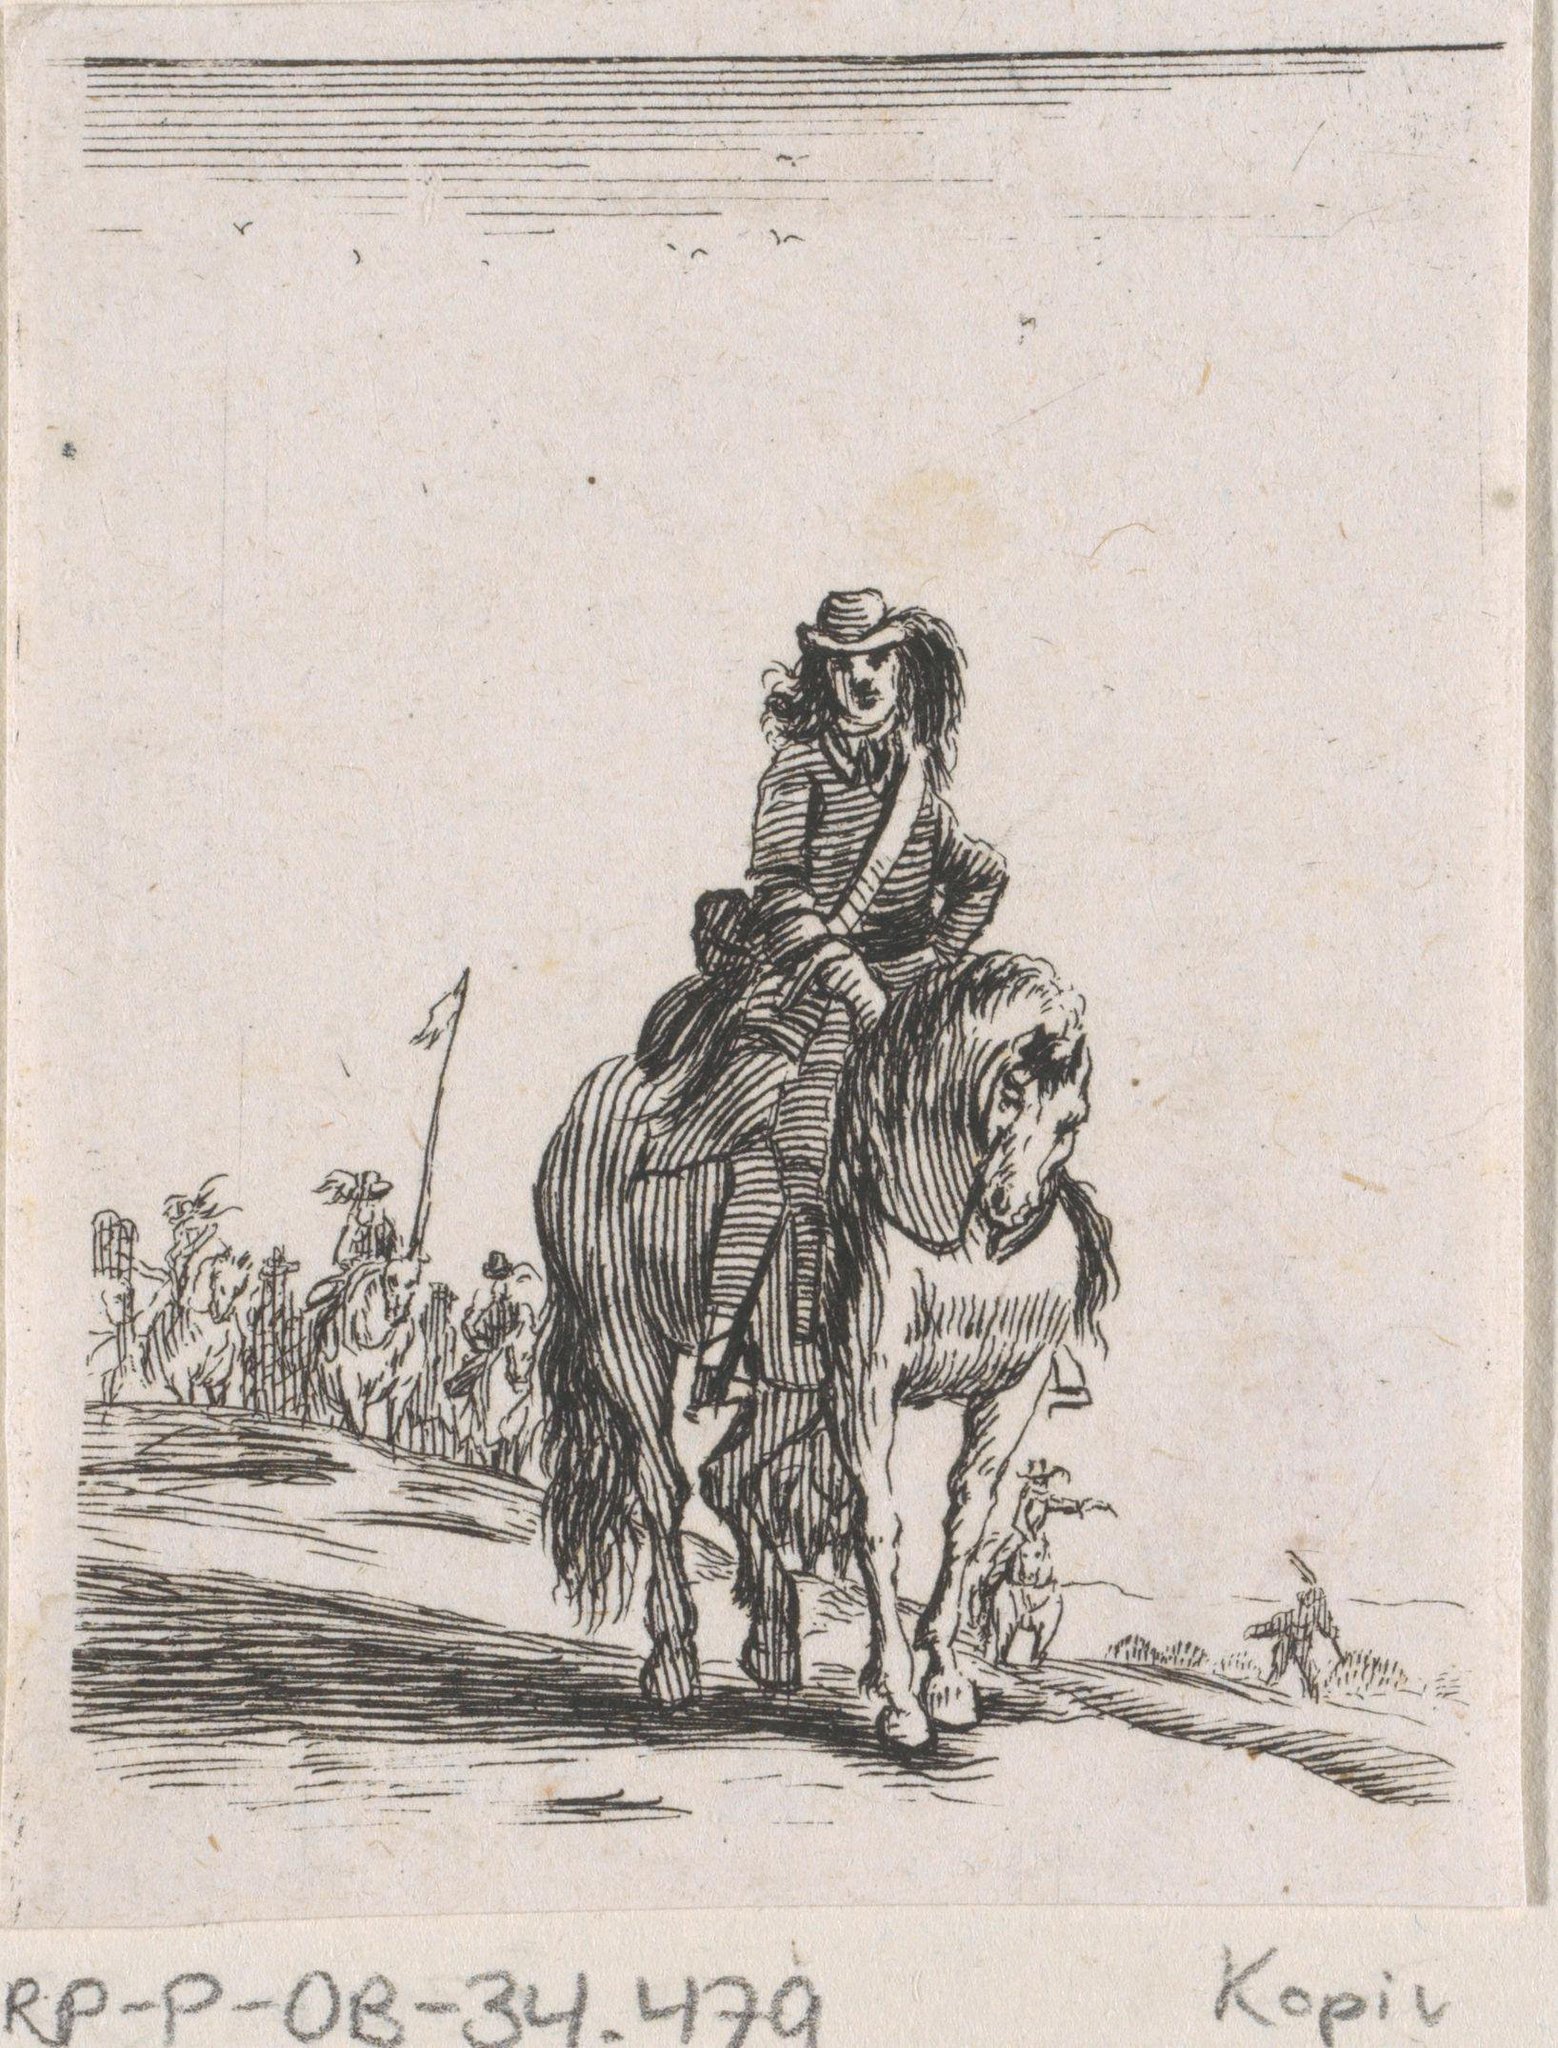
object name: print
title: Diverses exercices de cavalerie (kopie)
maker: Anonymous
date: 1620-1664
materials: paper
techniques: etching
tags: riding a horse, ass, or mule; rider, horseman, the soldier; the soldier's life, horse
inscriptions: collector's mark: Lugt 240